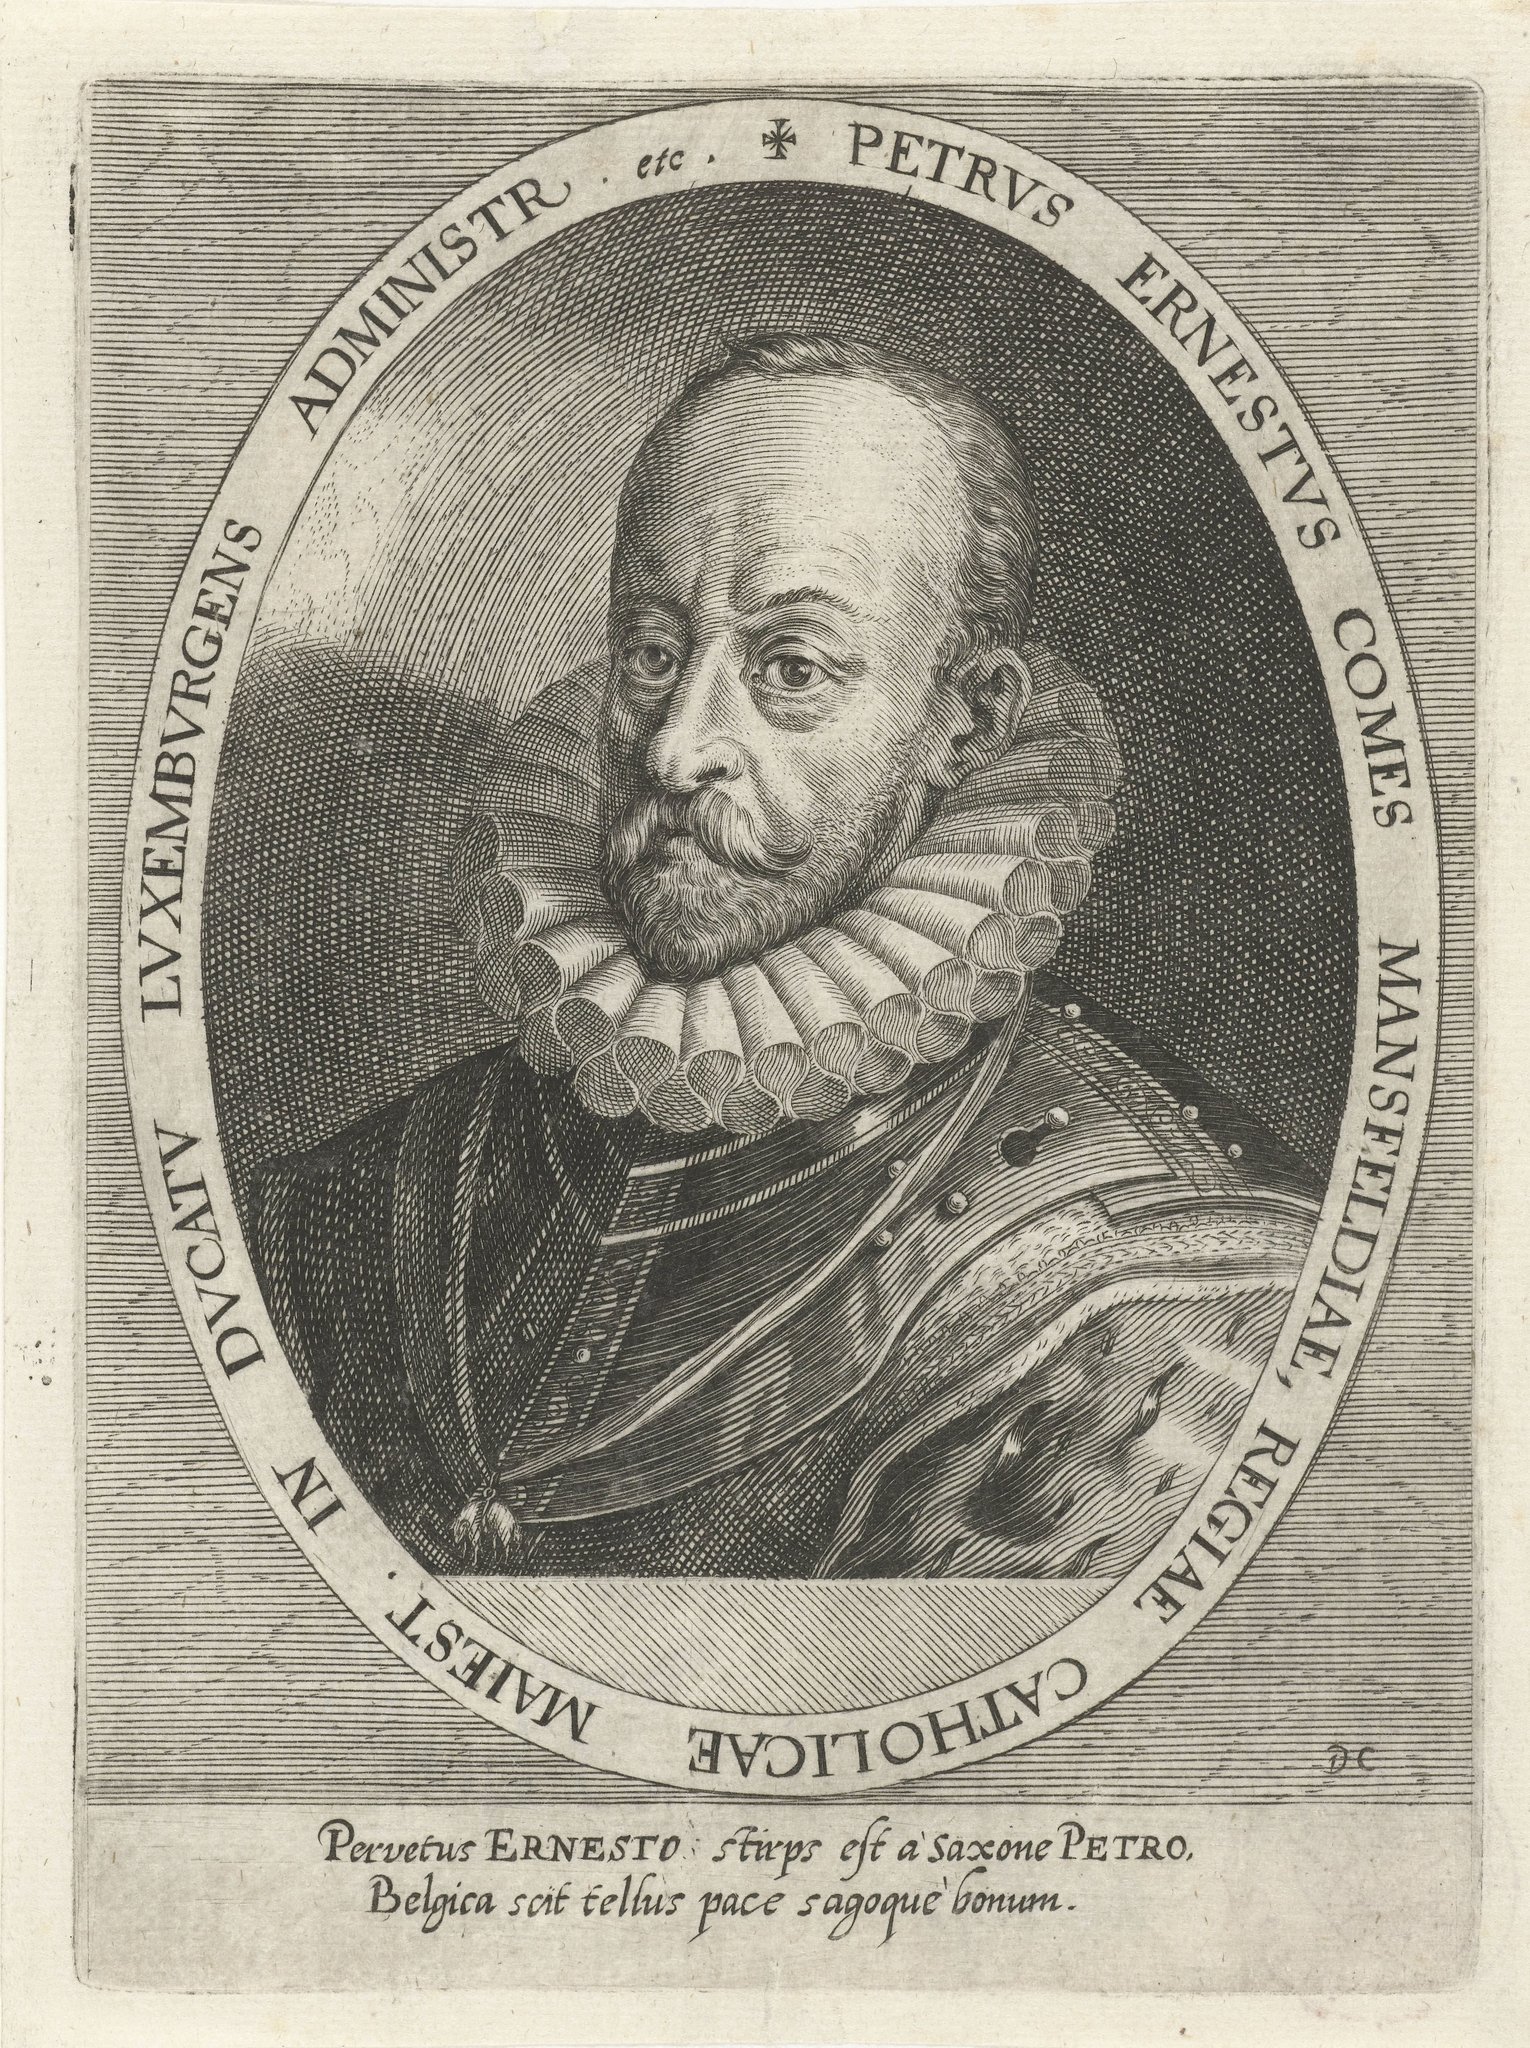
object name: print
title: Portret van Peter Ernst graaf van Mansfeld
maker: dominicus custos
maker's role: print maker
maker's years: 1560-1615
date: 1600-1604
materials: paper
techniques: engraving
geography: augsburg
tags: bevelhebber, peter ernst graaf van mansfeld (i)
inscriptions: collector's mark: Lugt 240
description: Illustratie uit: D. Custos en M. Henning. Atrium heroicum Caesarum, regum aliorq. summatum ac procerum qui intra proximum seculum vixere, aut hodie supersunt, imaginib. Deel 1-4. Augsburg: D. Custos, 1600-1604.